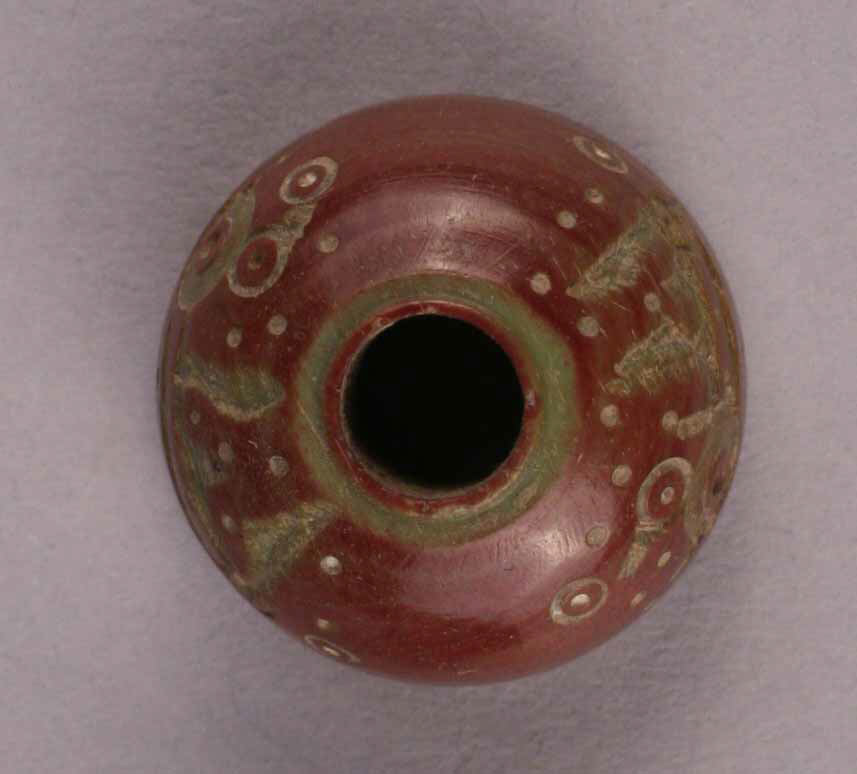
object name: spindle whorl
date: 801-1000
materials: bone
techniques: inlay, tinting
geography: iran